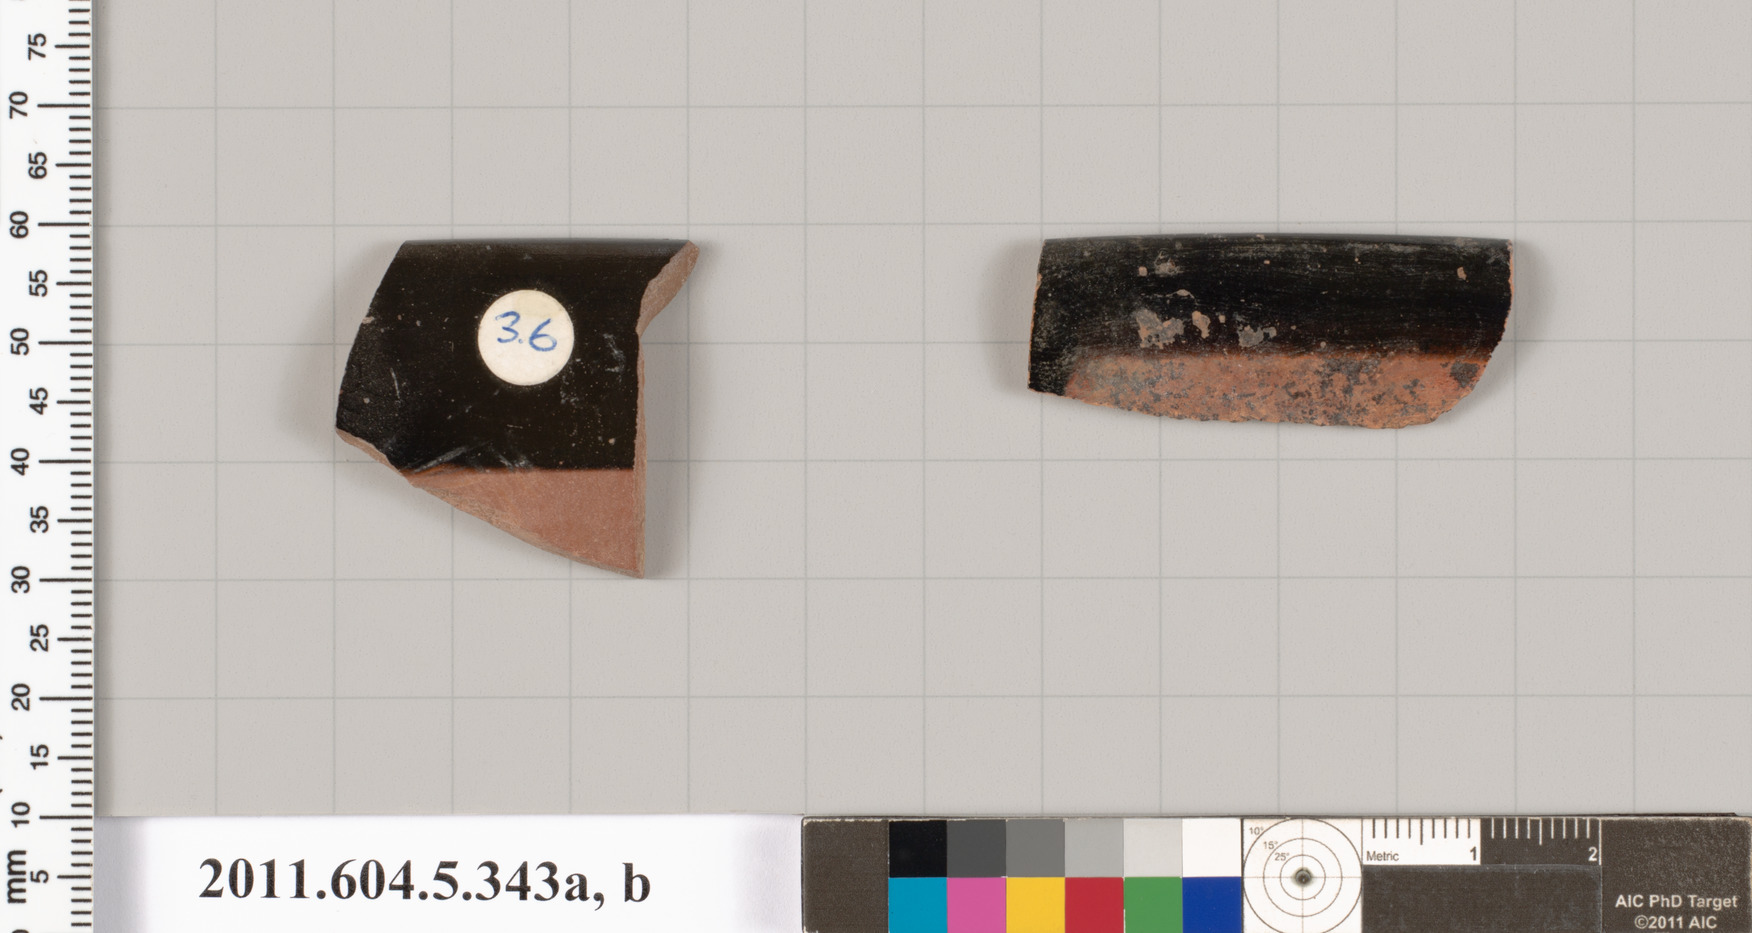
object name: kylix fragment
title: Terracotta rim fragments of kylikes (drinking cups)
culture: greek, attic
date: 600-401 BCE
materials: terracotta